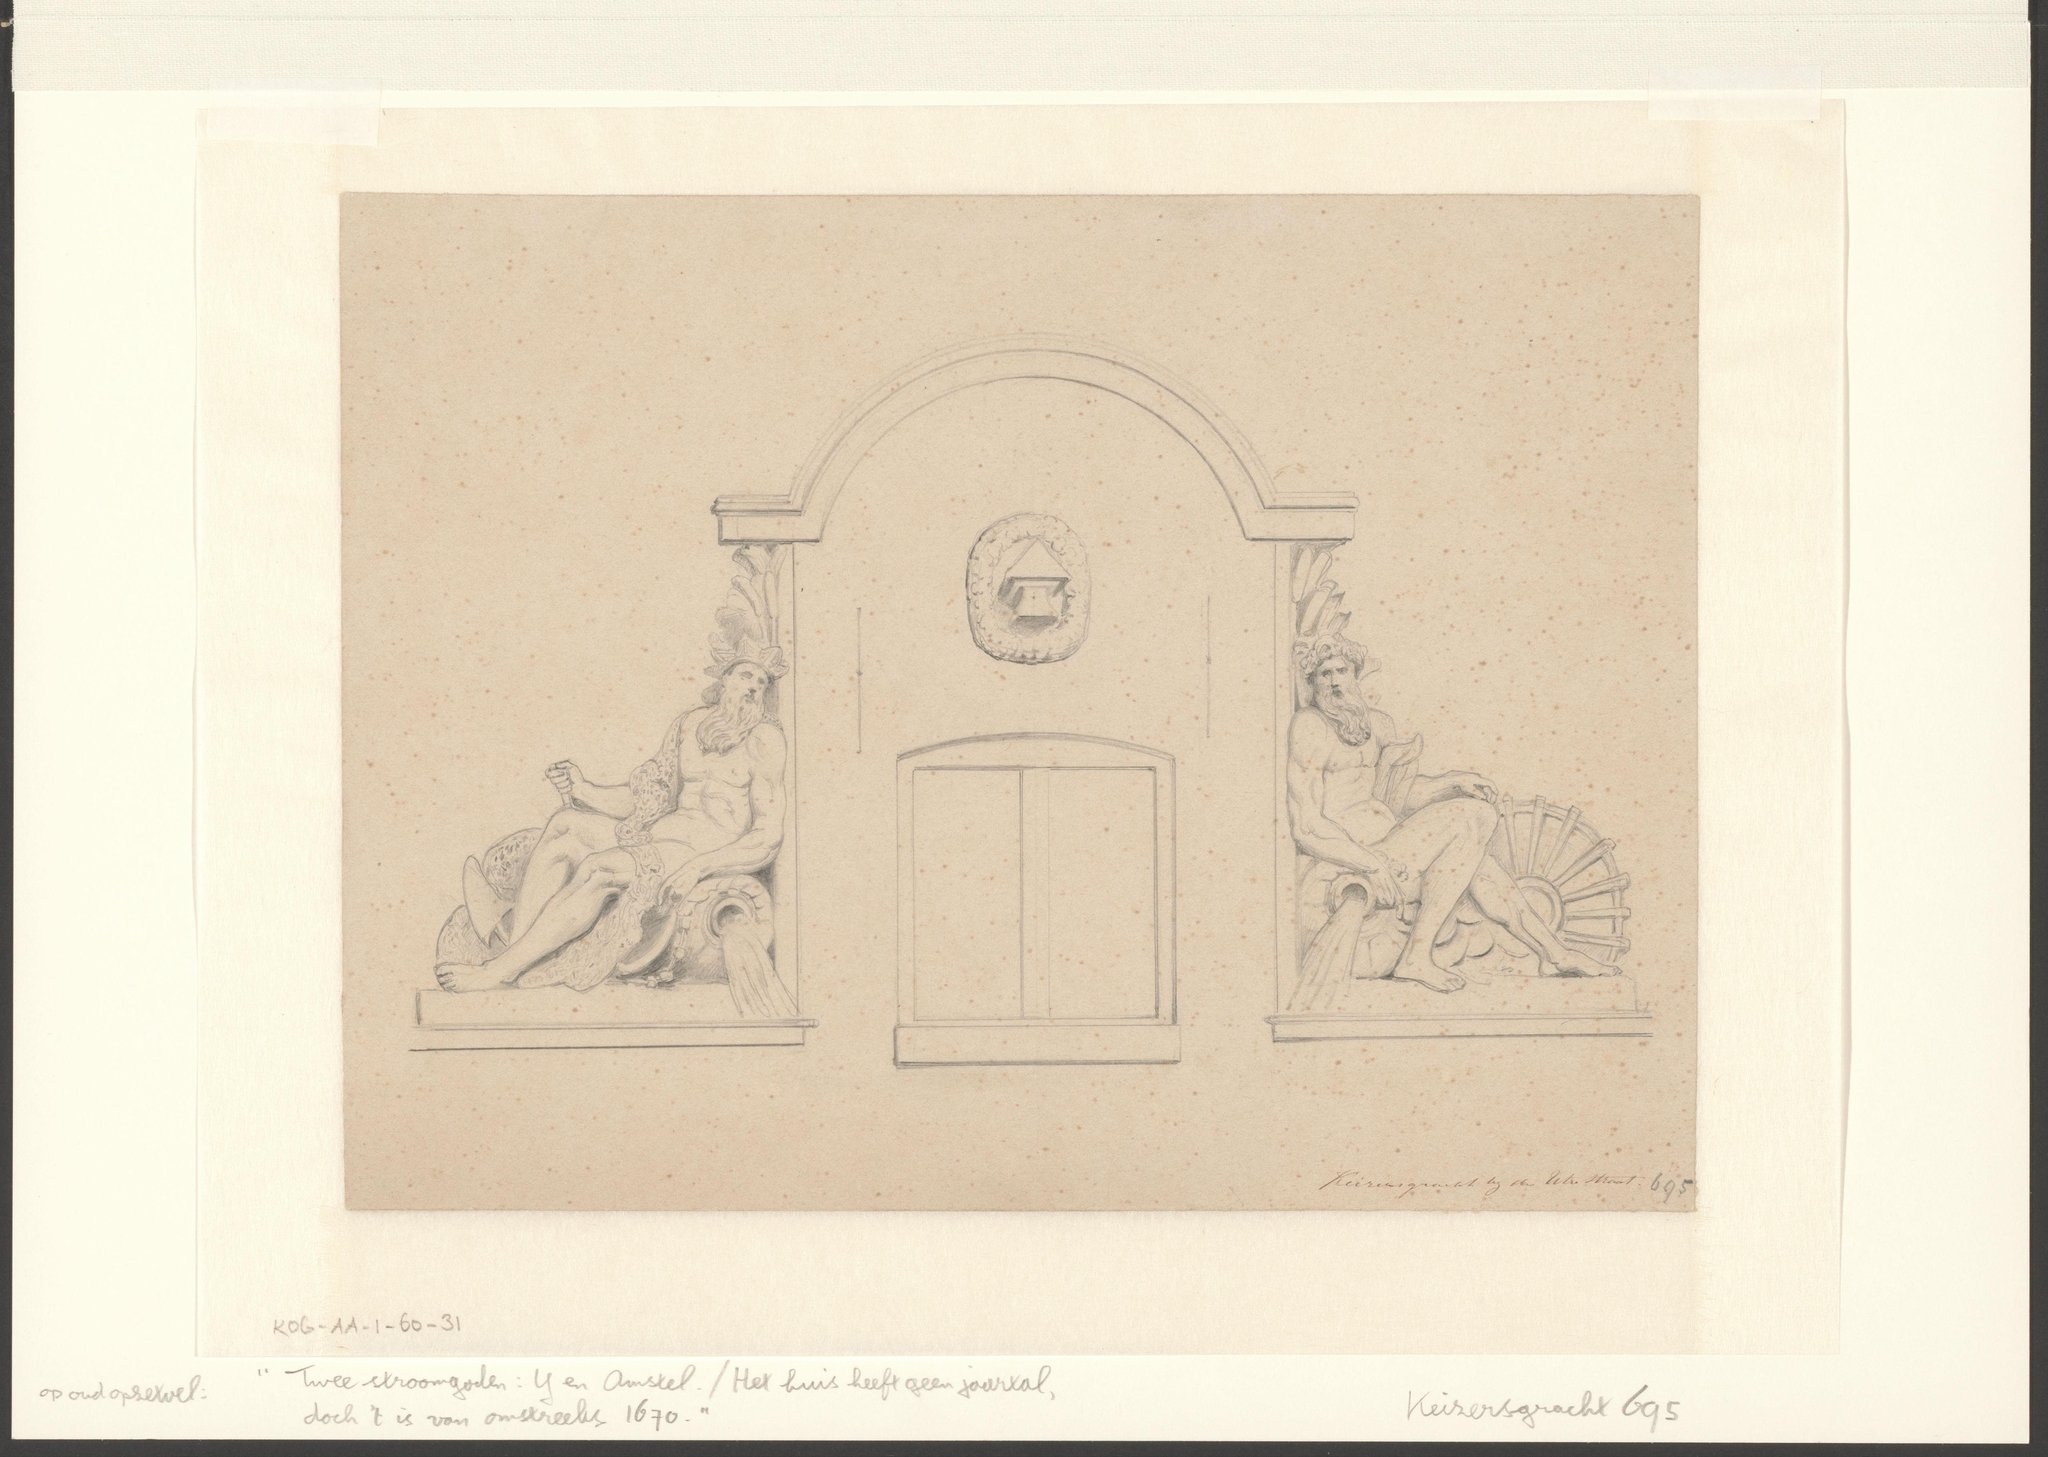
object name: drawing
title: Gezicht op de halsgevel van Keizersgracht 695 met de stroomgoden IJ en Amstel aan weerszijden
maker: Anonymous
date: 1850-1899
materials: paper, pencil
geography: amsterdam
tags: river-gods, front façade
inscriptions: inscription: ‘Keizersgracht by de Utr. straat. 695’, inscription: ‘op oud opzetvel: "Twee stroomgoden: Y en Amstel. / Het huis heeft geen jaartal, / doch 't is van omstreeks 1670." / Keizersgracht 695’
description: Onderwerpsrubriek binnen de Atlas Amsterdam: Bouwkunst - Enkele huizen.